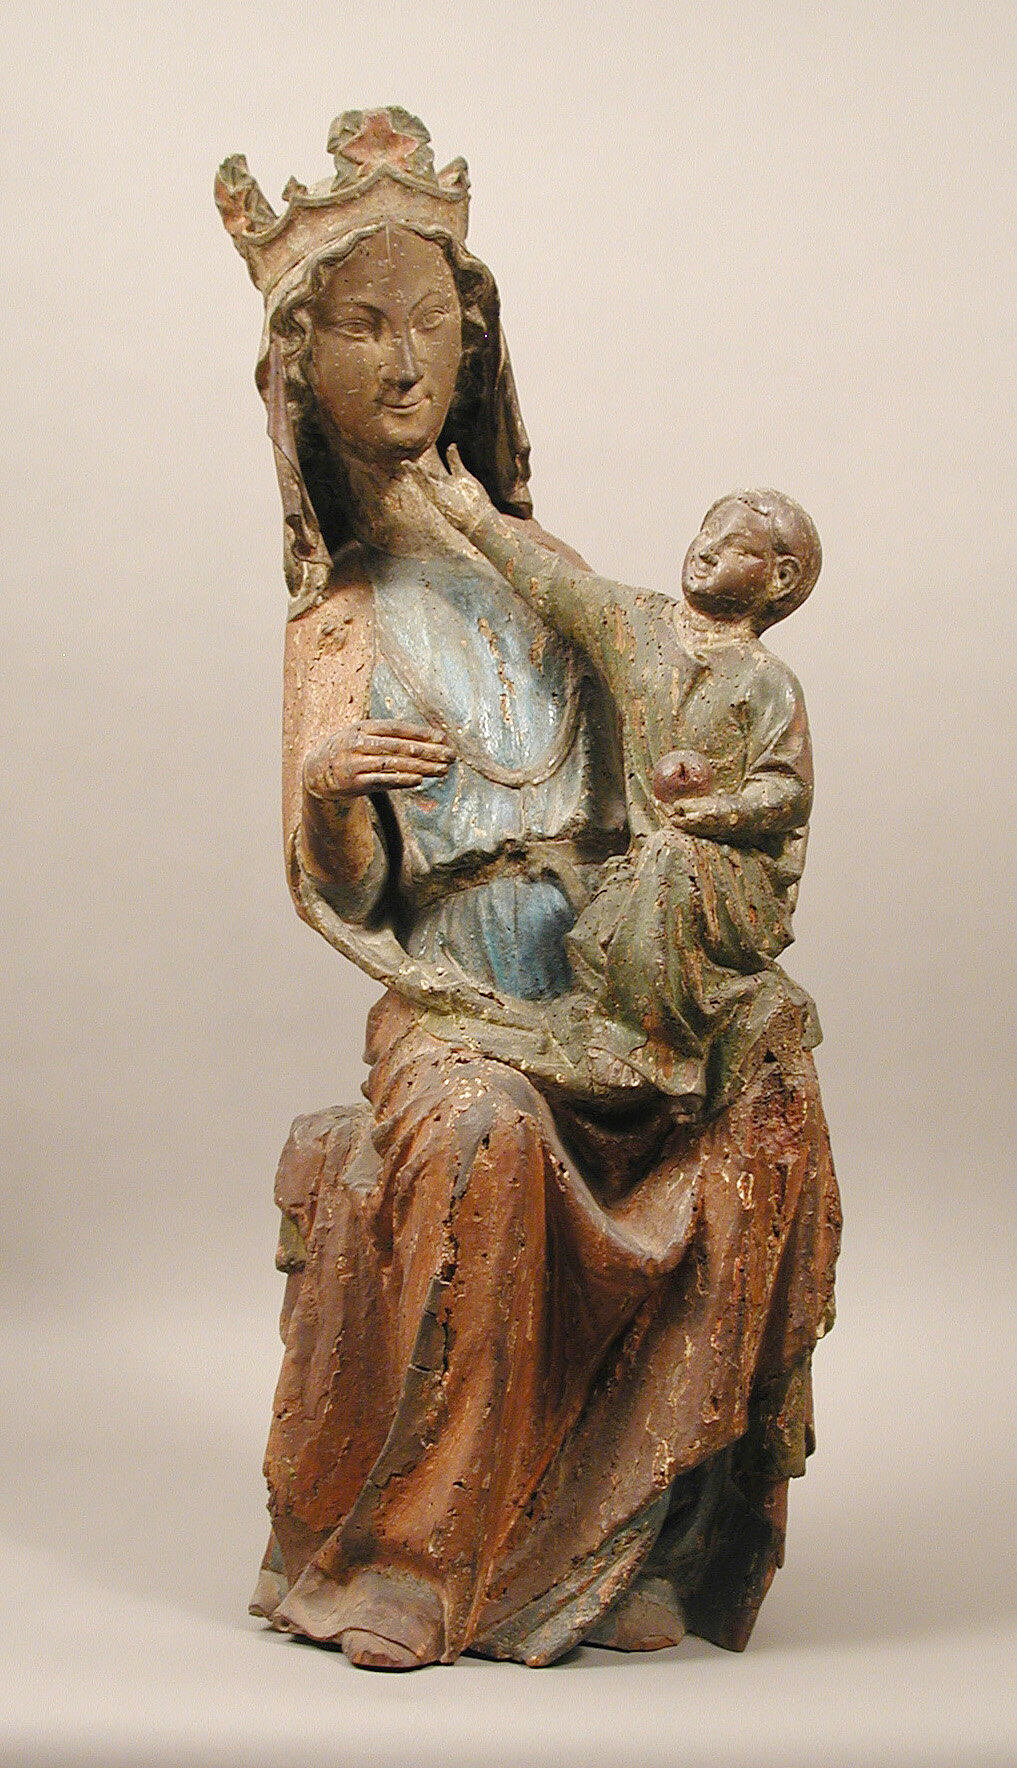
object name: statuette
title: Virgin and Child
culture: french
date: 1201-1400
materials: wood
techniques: polychromy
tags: christ,virgin mary